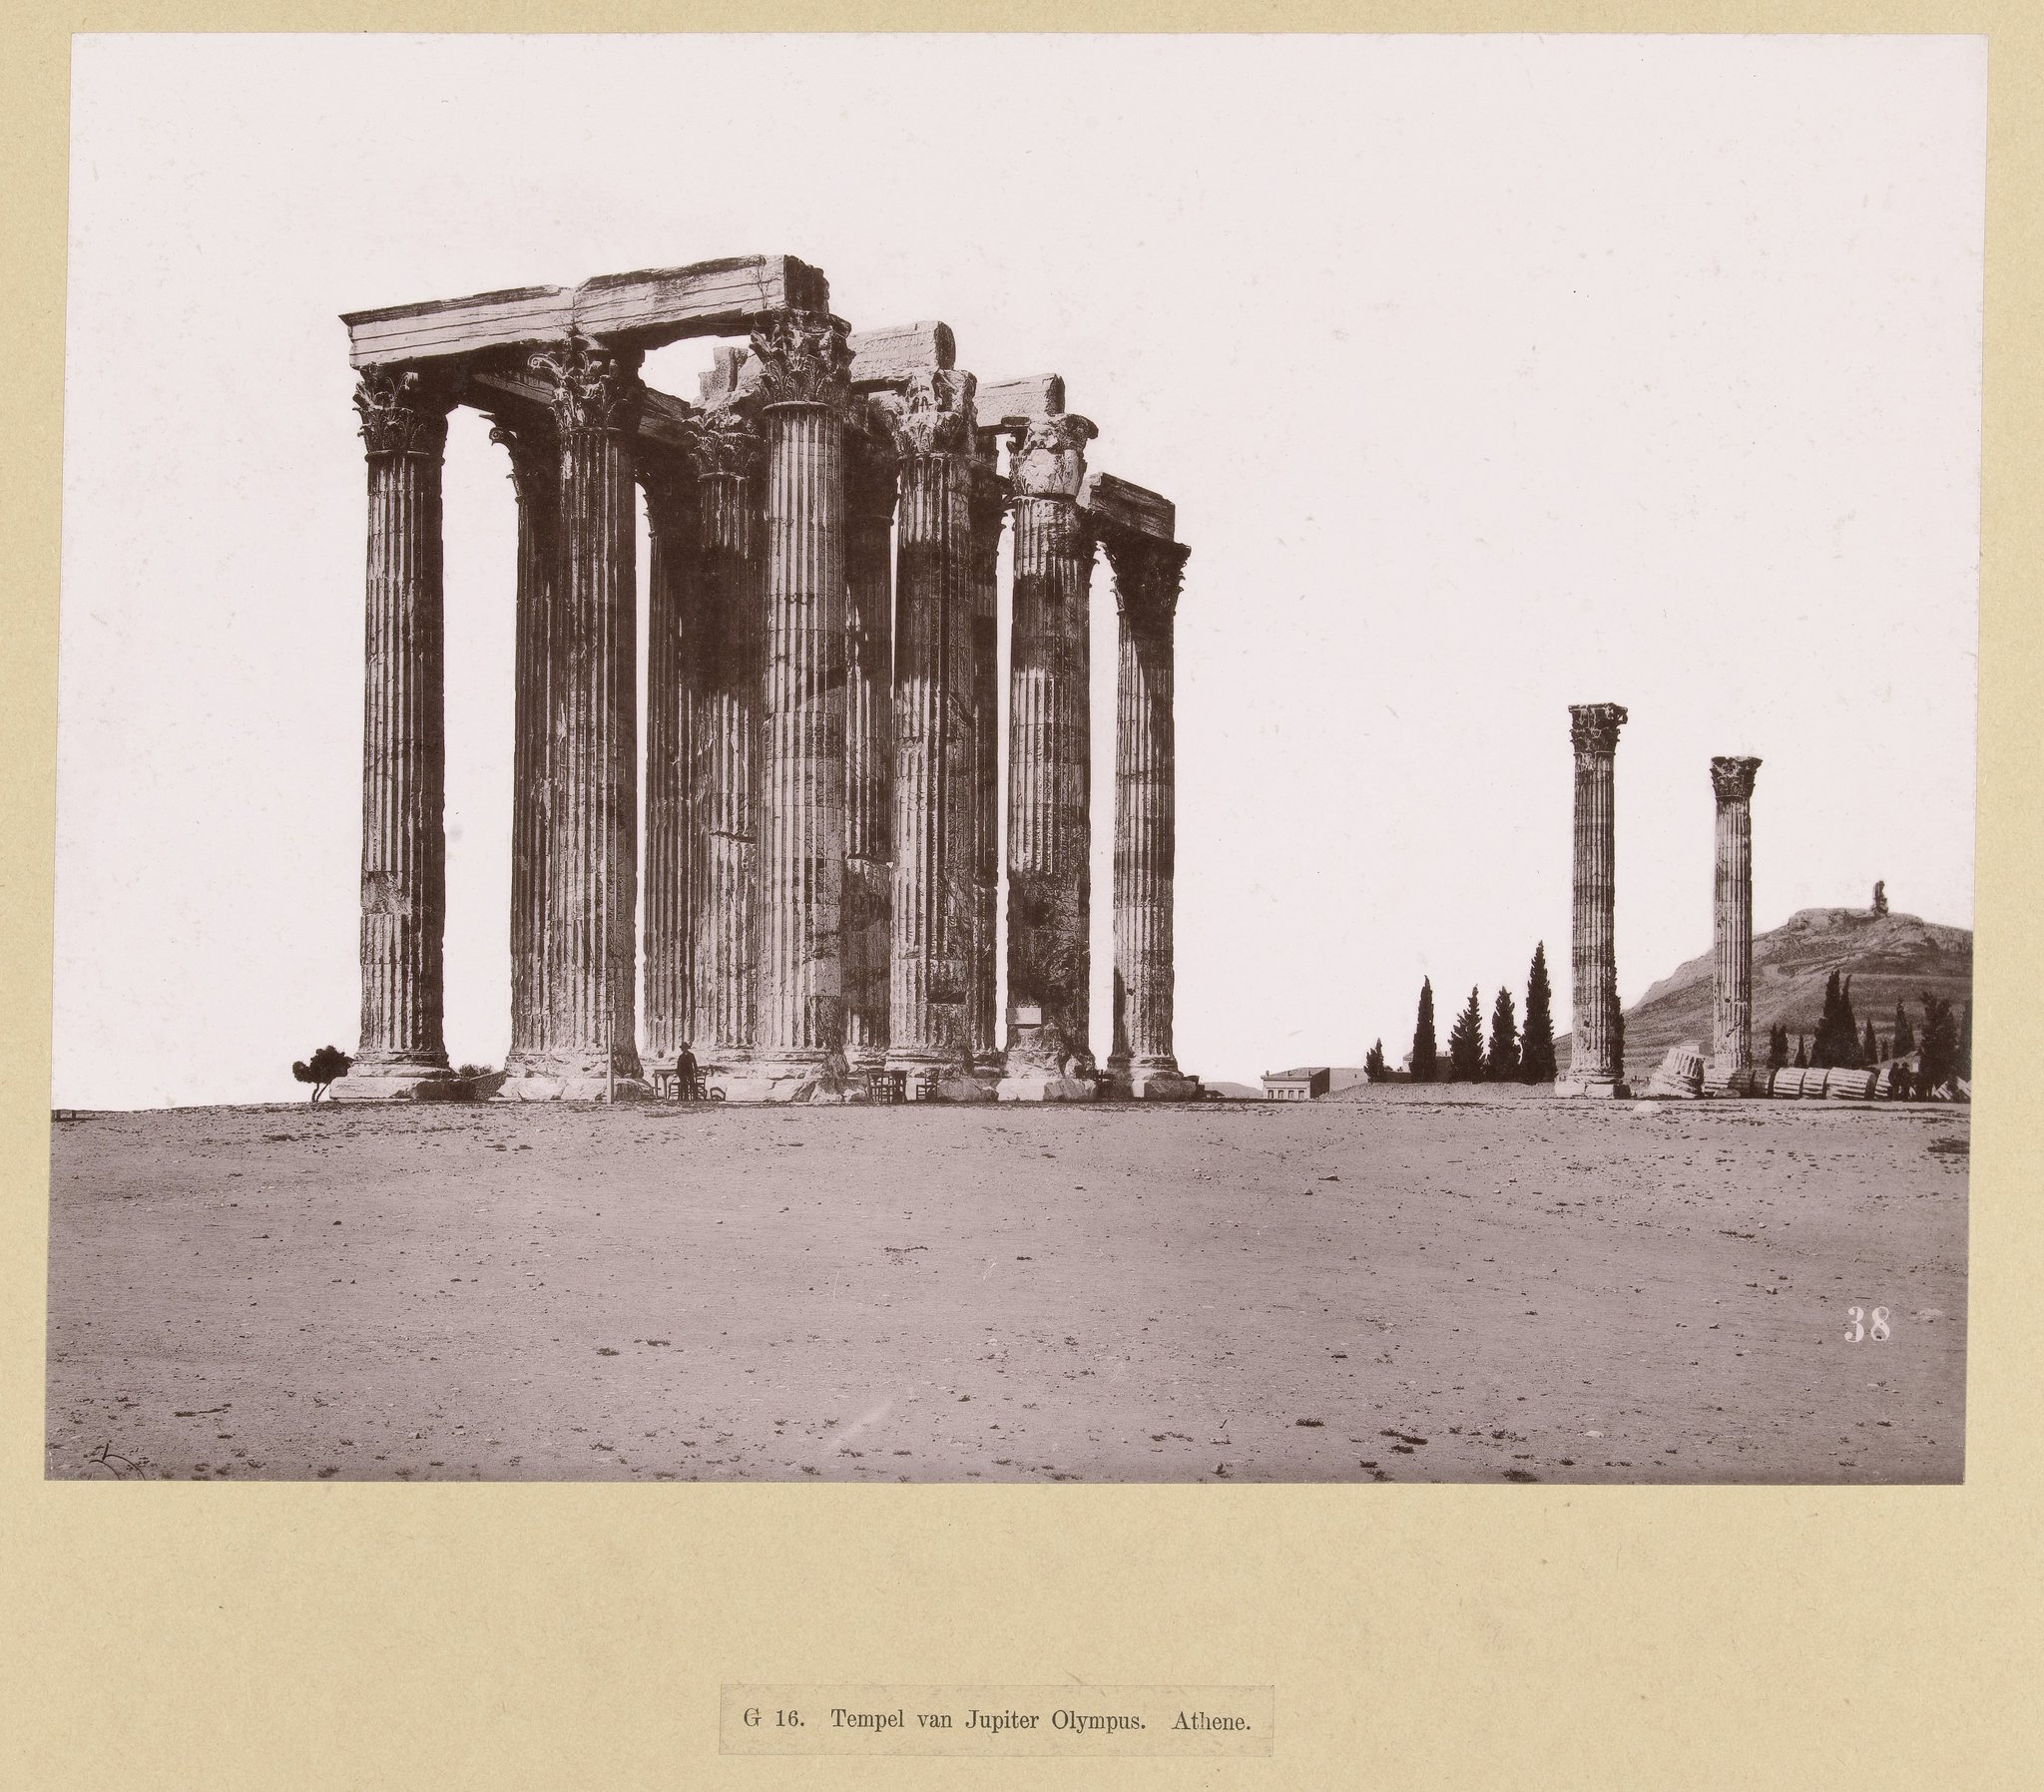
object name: photomechanical print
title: G 16. Tempel van Jupiter Olympus. Athene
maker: Anonymous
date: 1890-1893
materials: cardboard, paper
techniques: photograph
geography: athens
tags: column, pillar ~ architecture, ruin of a building ~ architecture, temple, shrine ~ greek religion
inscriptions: title: ‘G 16. Tempel van Jupiter Olympus. Athene.’, stamp: ‘Gemeentelijke bibliotheek/ Rotterdam’, number: ‘38’, check stamp: ‘Bristol/ L.M.’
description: Onderdeel van een groep door fotograaf Richard Polak op reis verzamelde foto’s. Deze fotomechanische afdruk is samen met andere op zijn reizen verzamelde foto's tentoongesteld bij de Rotterdamsche Kunstkring (1895), Arti en Amicitiae te Amsterdam (1897-1898?) en Societeit 't Collegie te Kampen (datum vooralsnog onbekend).